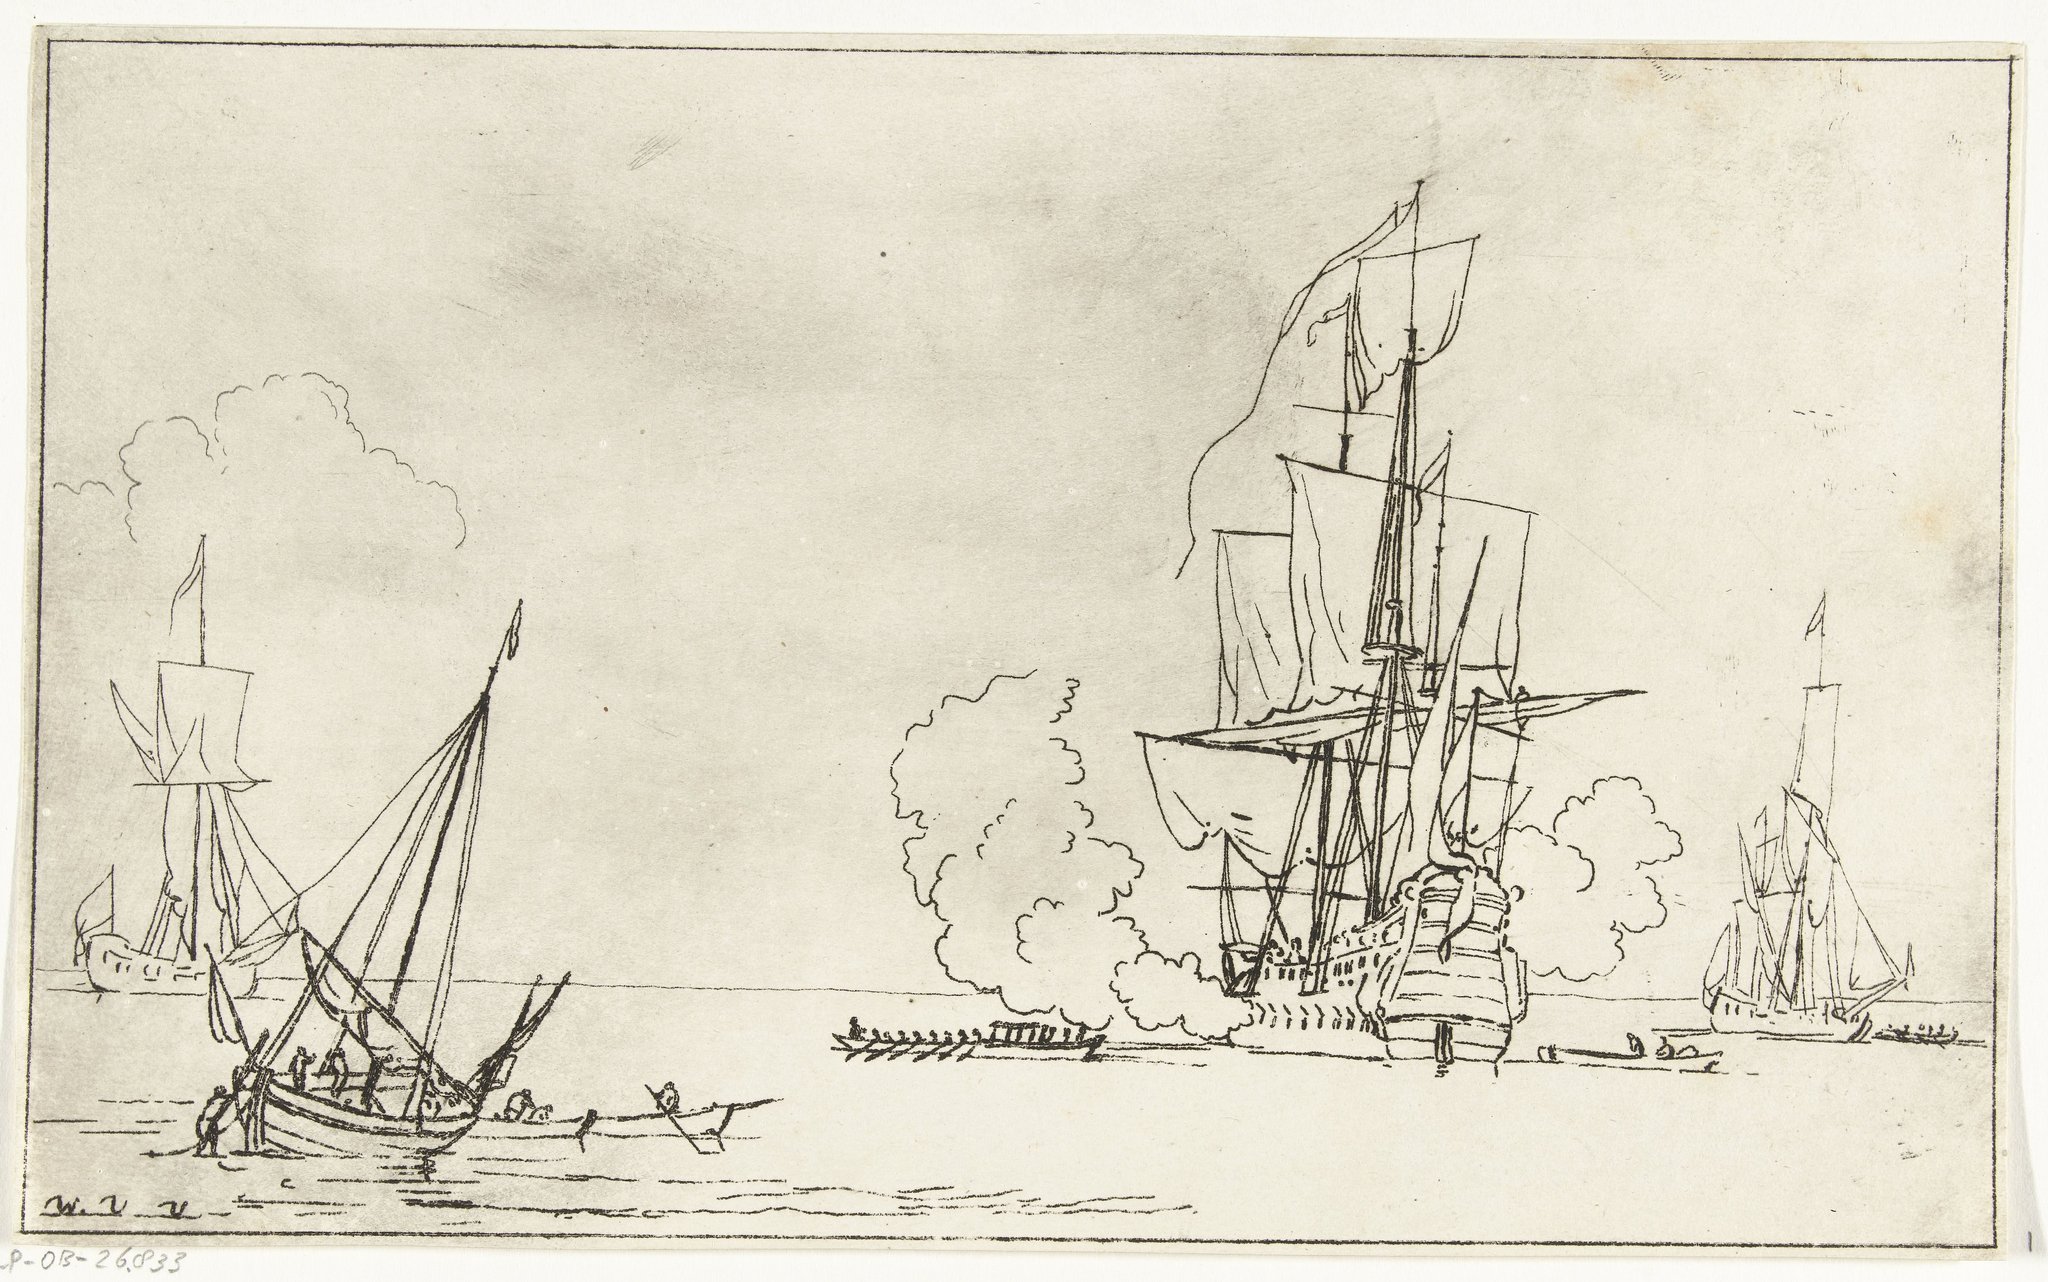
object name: print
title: Zeeslag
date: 1778-1838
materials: paper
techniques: etching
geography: netherlands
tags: battle (+ sailing-ships)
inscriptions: collector's mark: Lugt 2228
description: Een oorlogsschip bij windstilte met slappe zeilen lost een kanonschot. Aan weerszijden twee sloepen, in de verte twee kleinere schepen. Een ander schip wordt door de bemanning aan het strand getrokken.